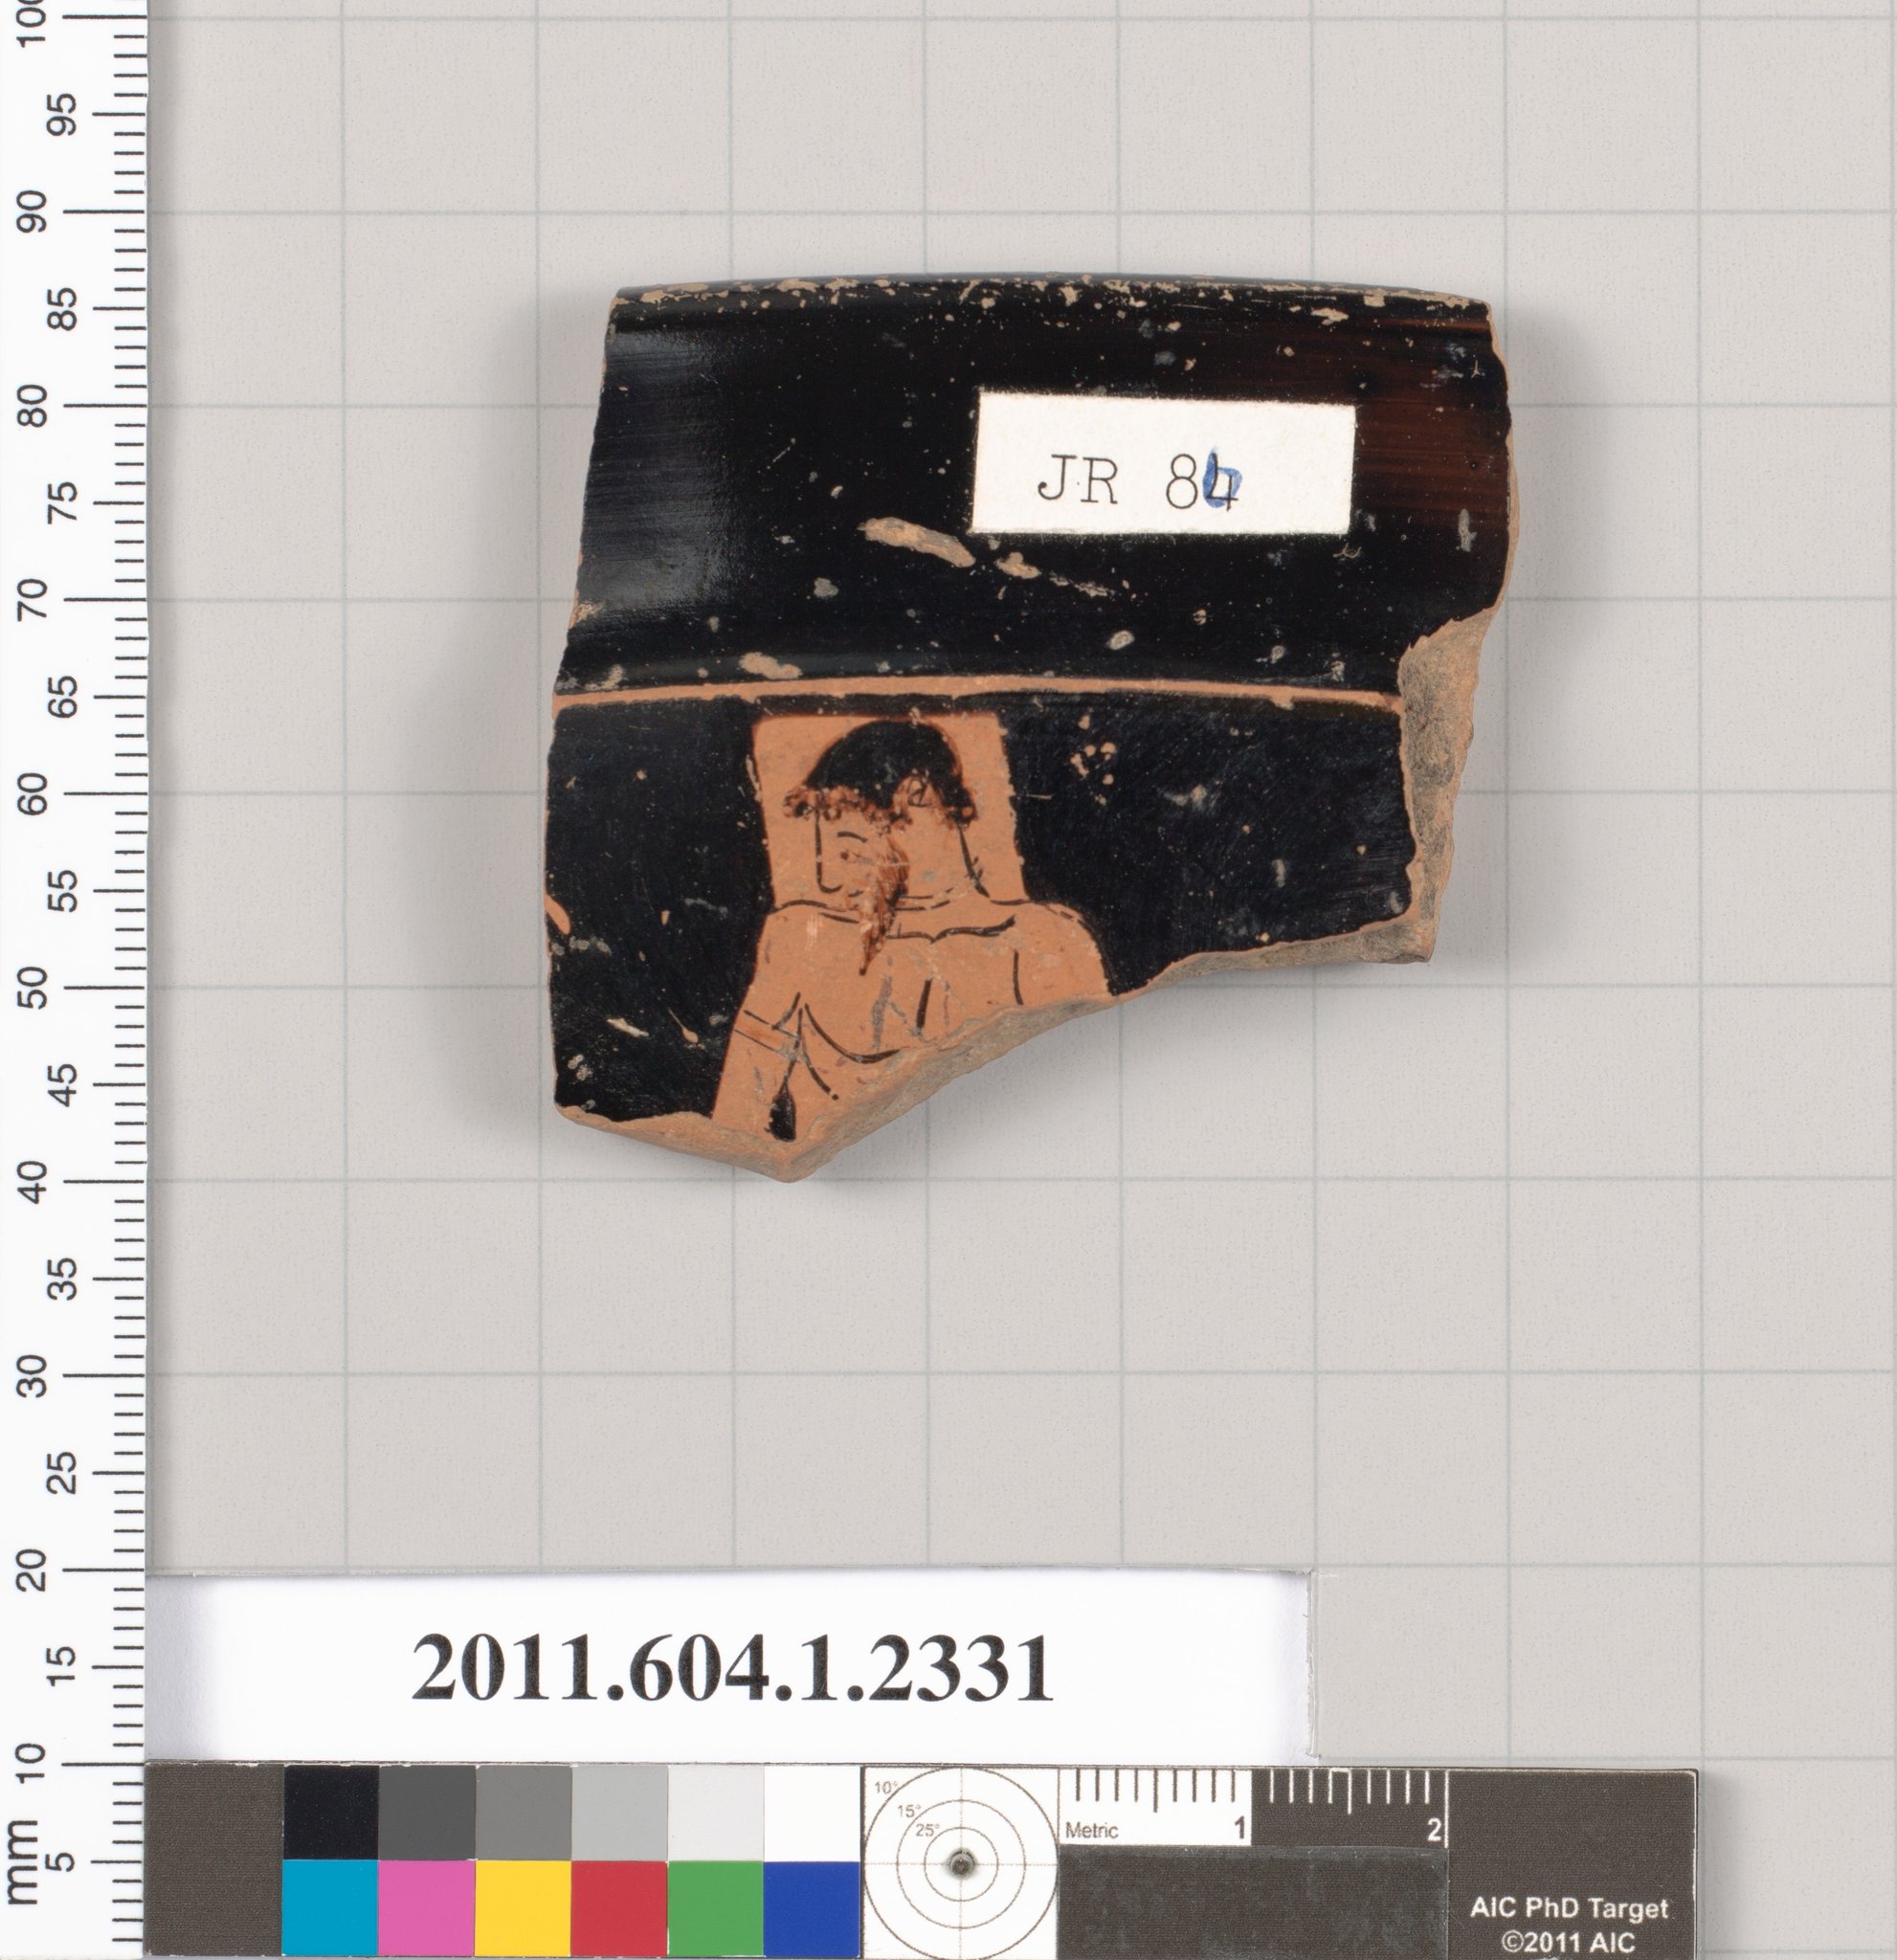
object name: kylix fragment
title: Terracotta rim fragment of a kylix (drinking cup)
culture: greek, attic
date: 460-450 BCE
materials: terracotta